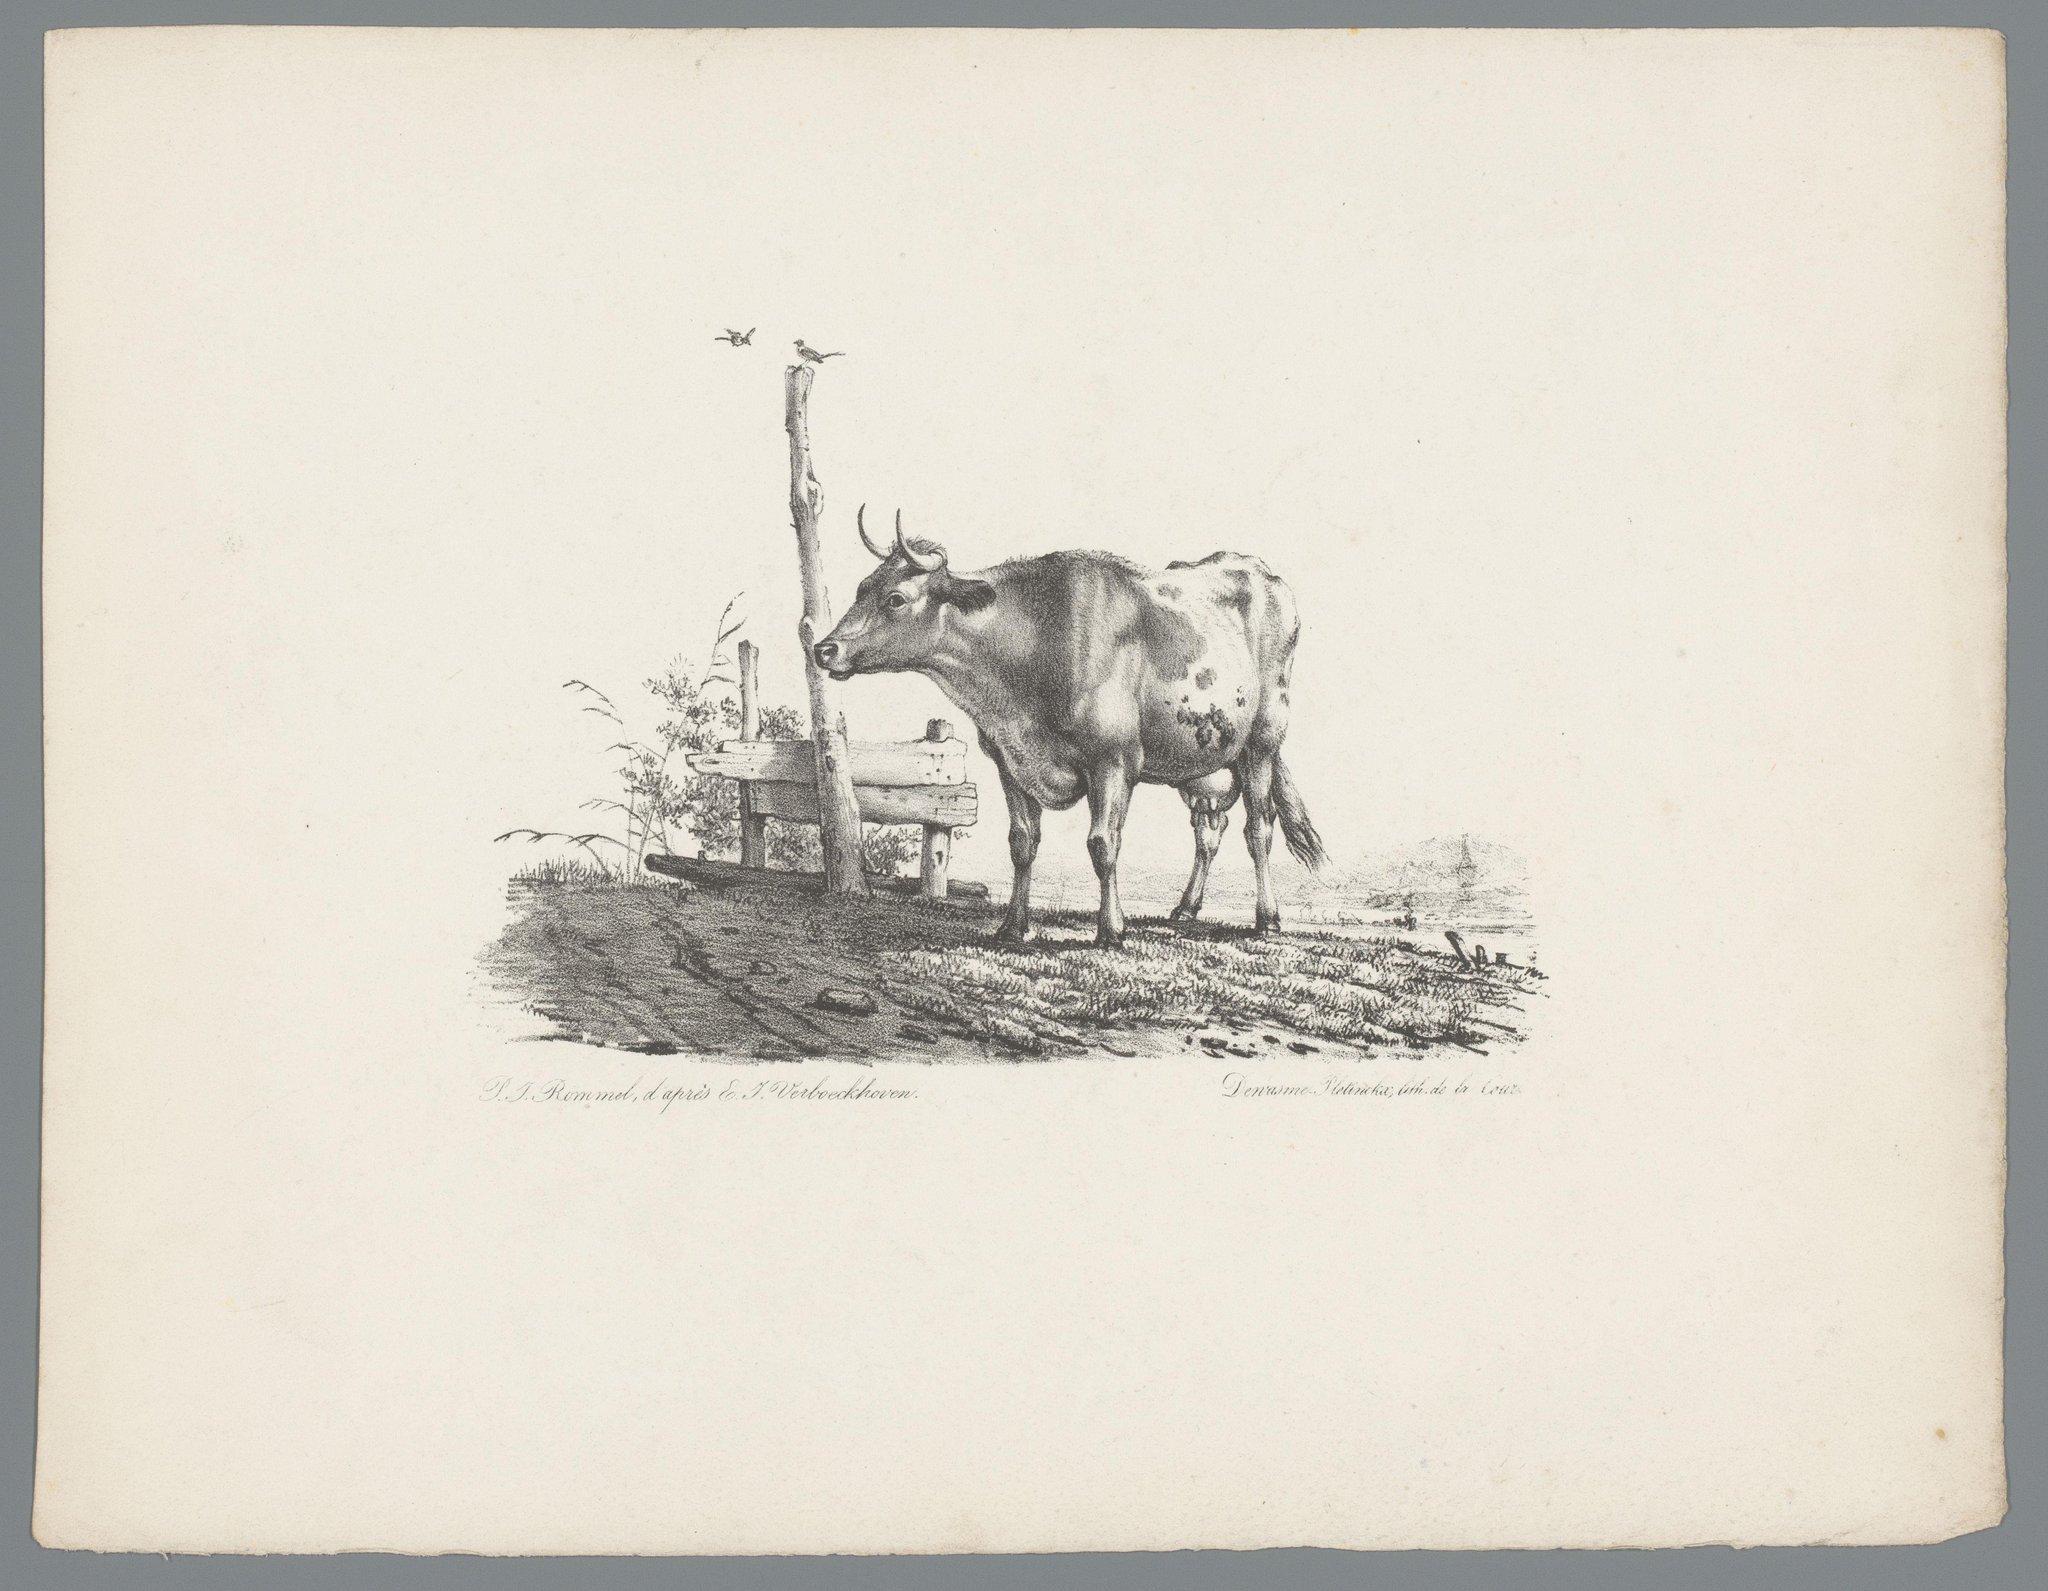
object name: print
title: Koe bij een hek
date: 1824-1827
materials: paper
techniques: lithograph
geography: brussels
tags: cow